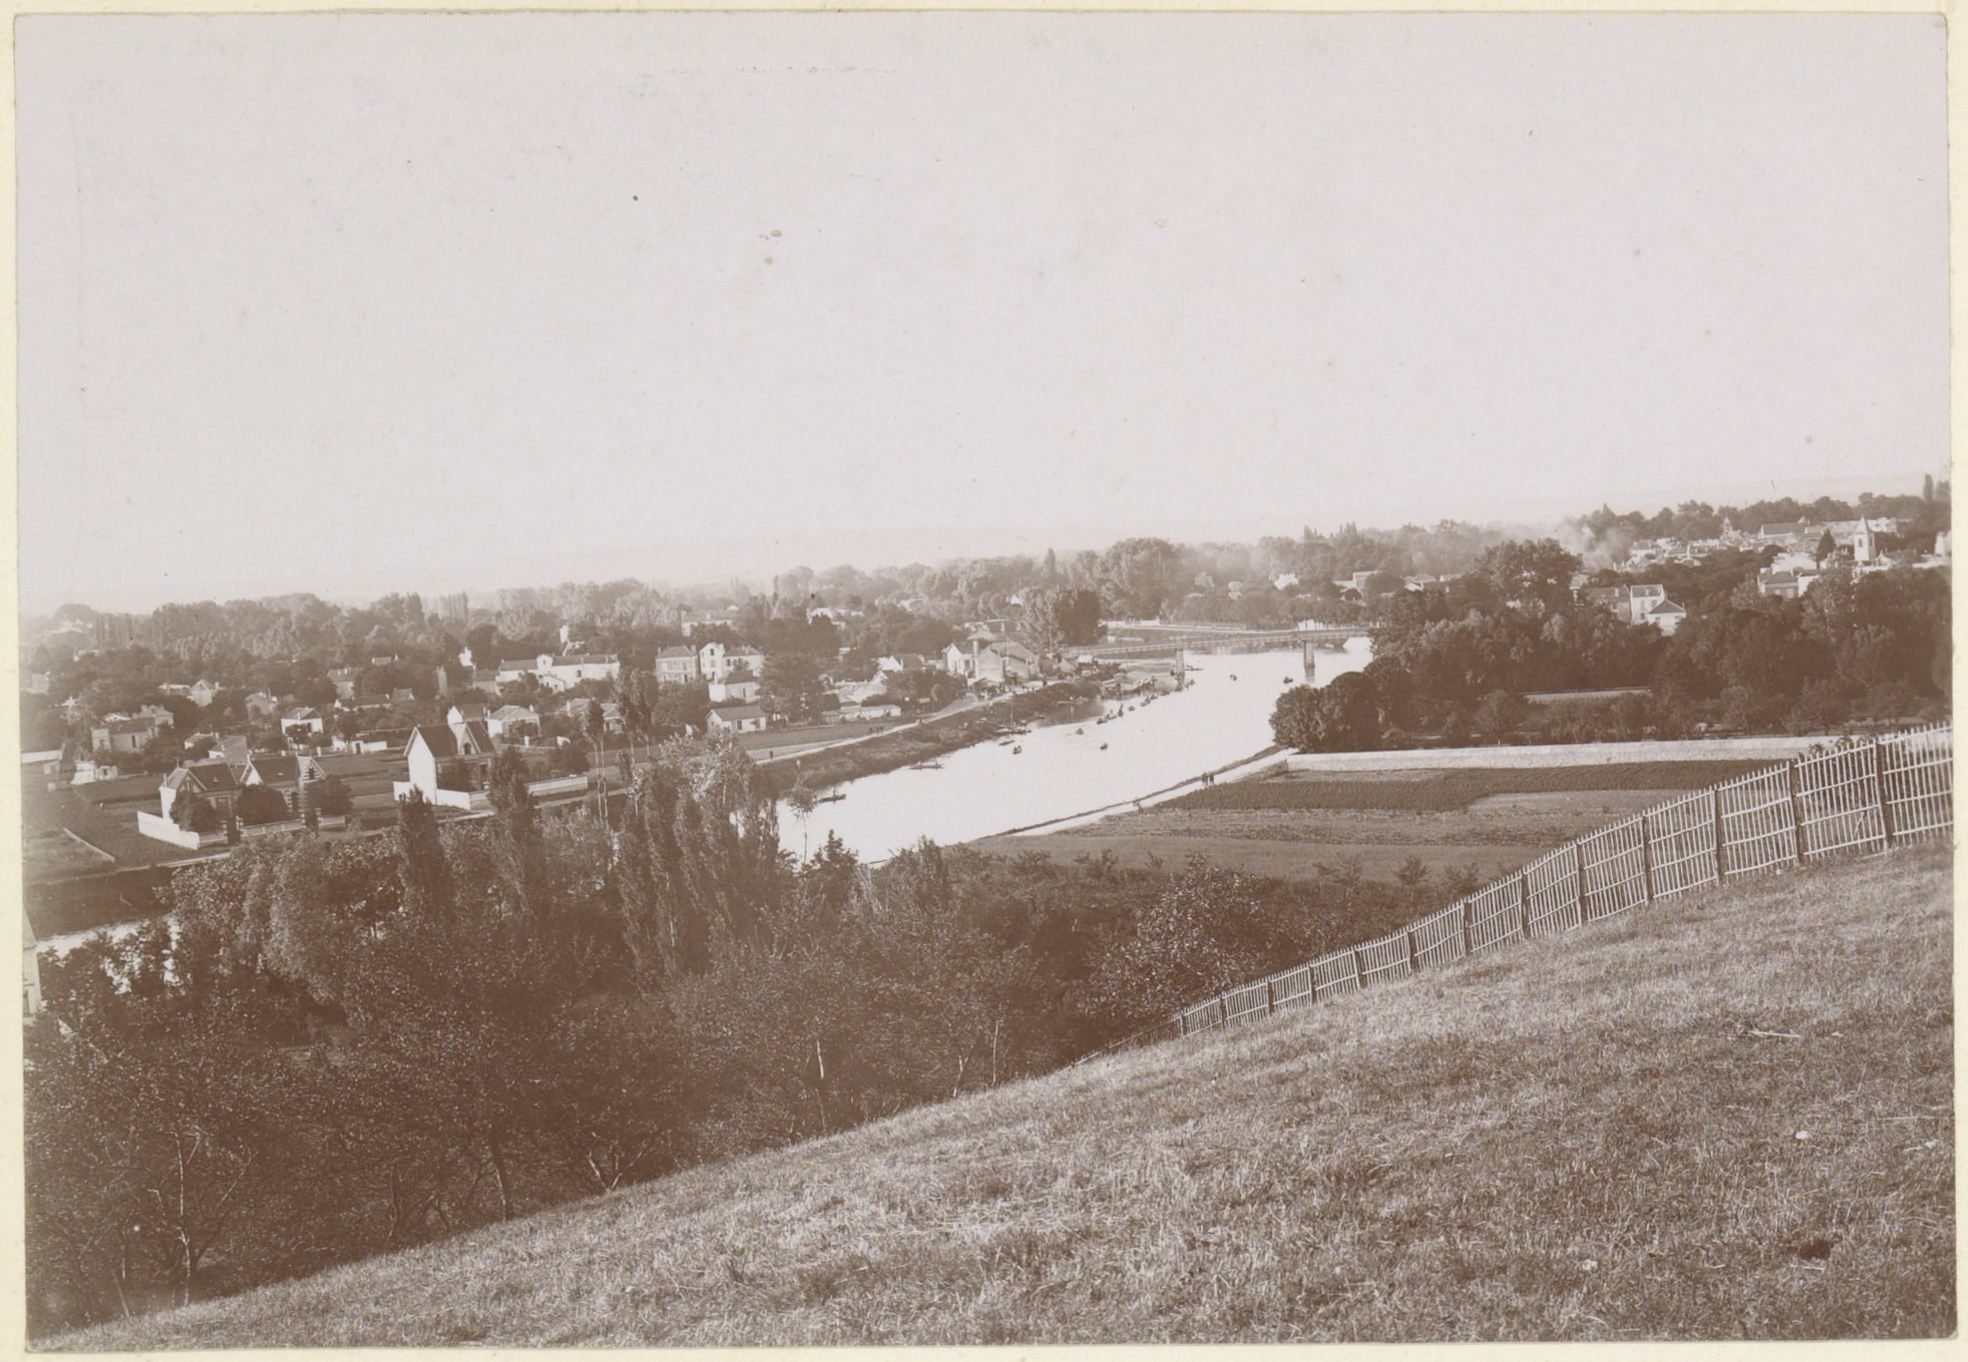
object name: photograph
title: Gezicht op een dorp aan een rivier, vermoedelijk in Frankrijk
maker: Anonymous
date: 1900-1910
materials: paper, photographic support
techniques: daylight paper print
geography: france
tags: prospect of village, silhouette of village, river bank, river (+ landscape with figures, staffage), france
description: Onderdeel van Fotoalbum van een Franse amateurfotograaf met opnames van een familie, distilleerderij Delizy & Doistau Fils, het leger en bezienswaardigheden in Frankrijk.